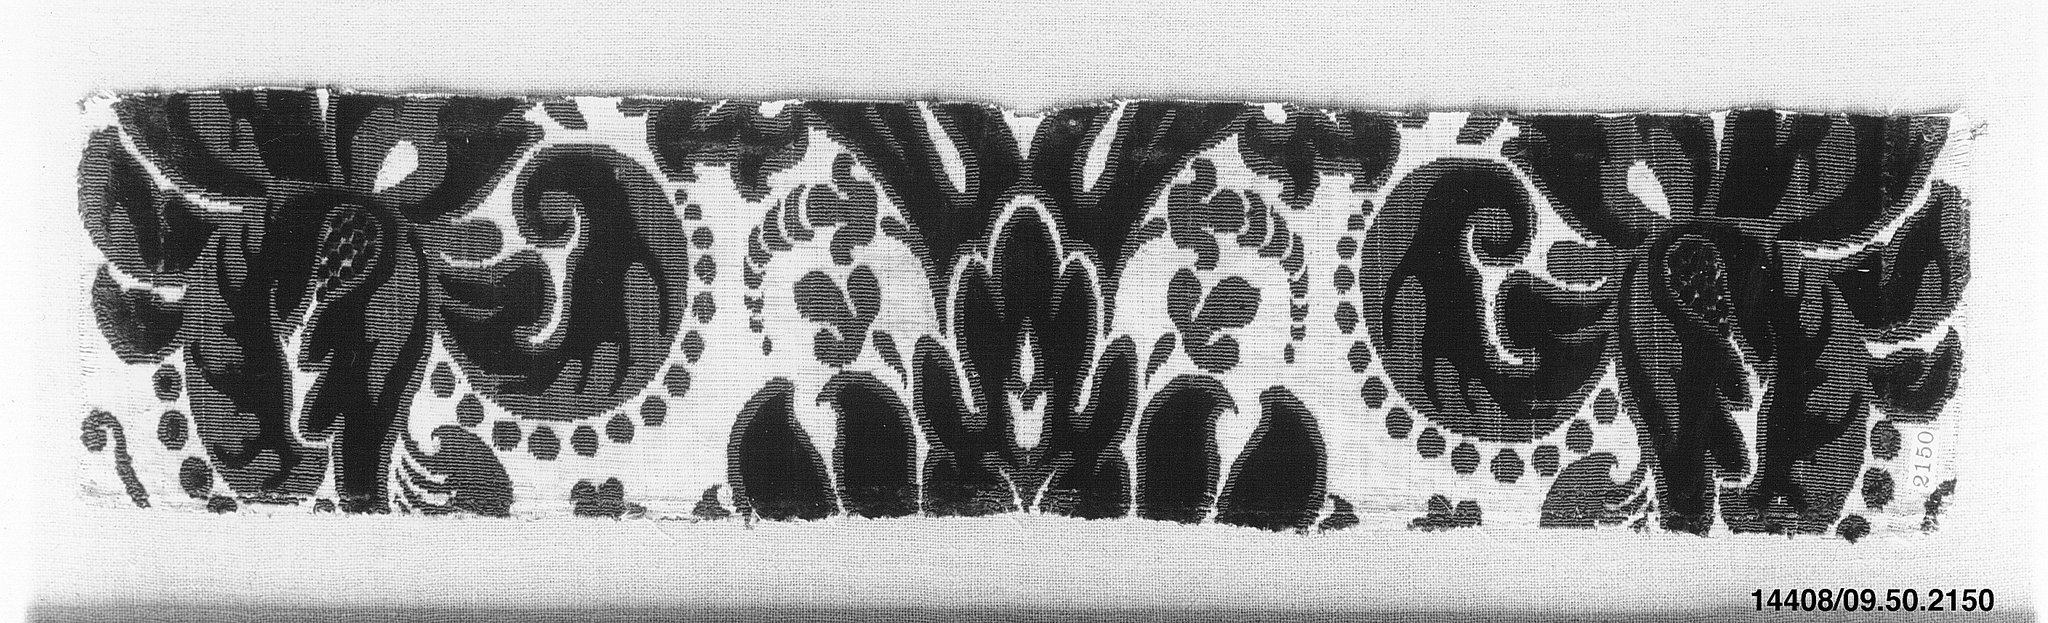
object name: piece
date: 1601-1700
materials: metal thread, silk